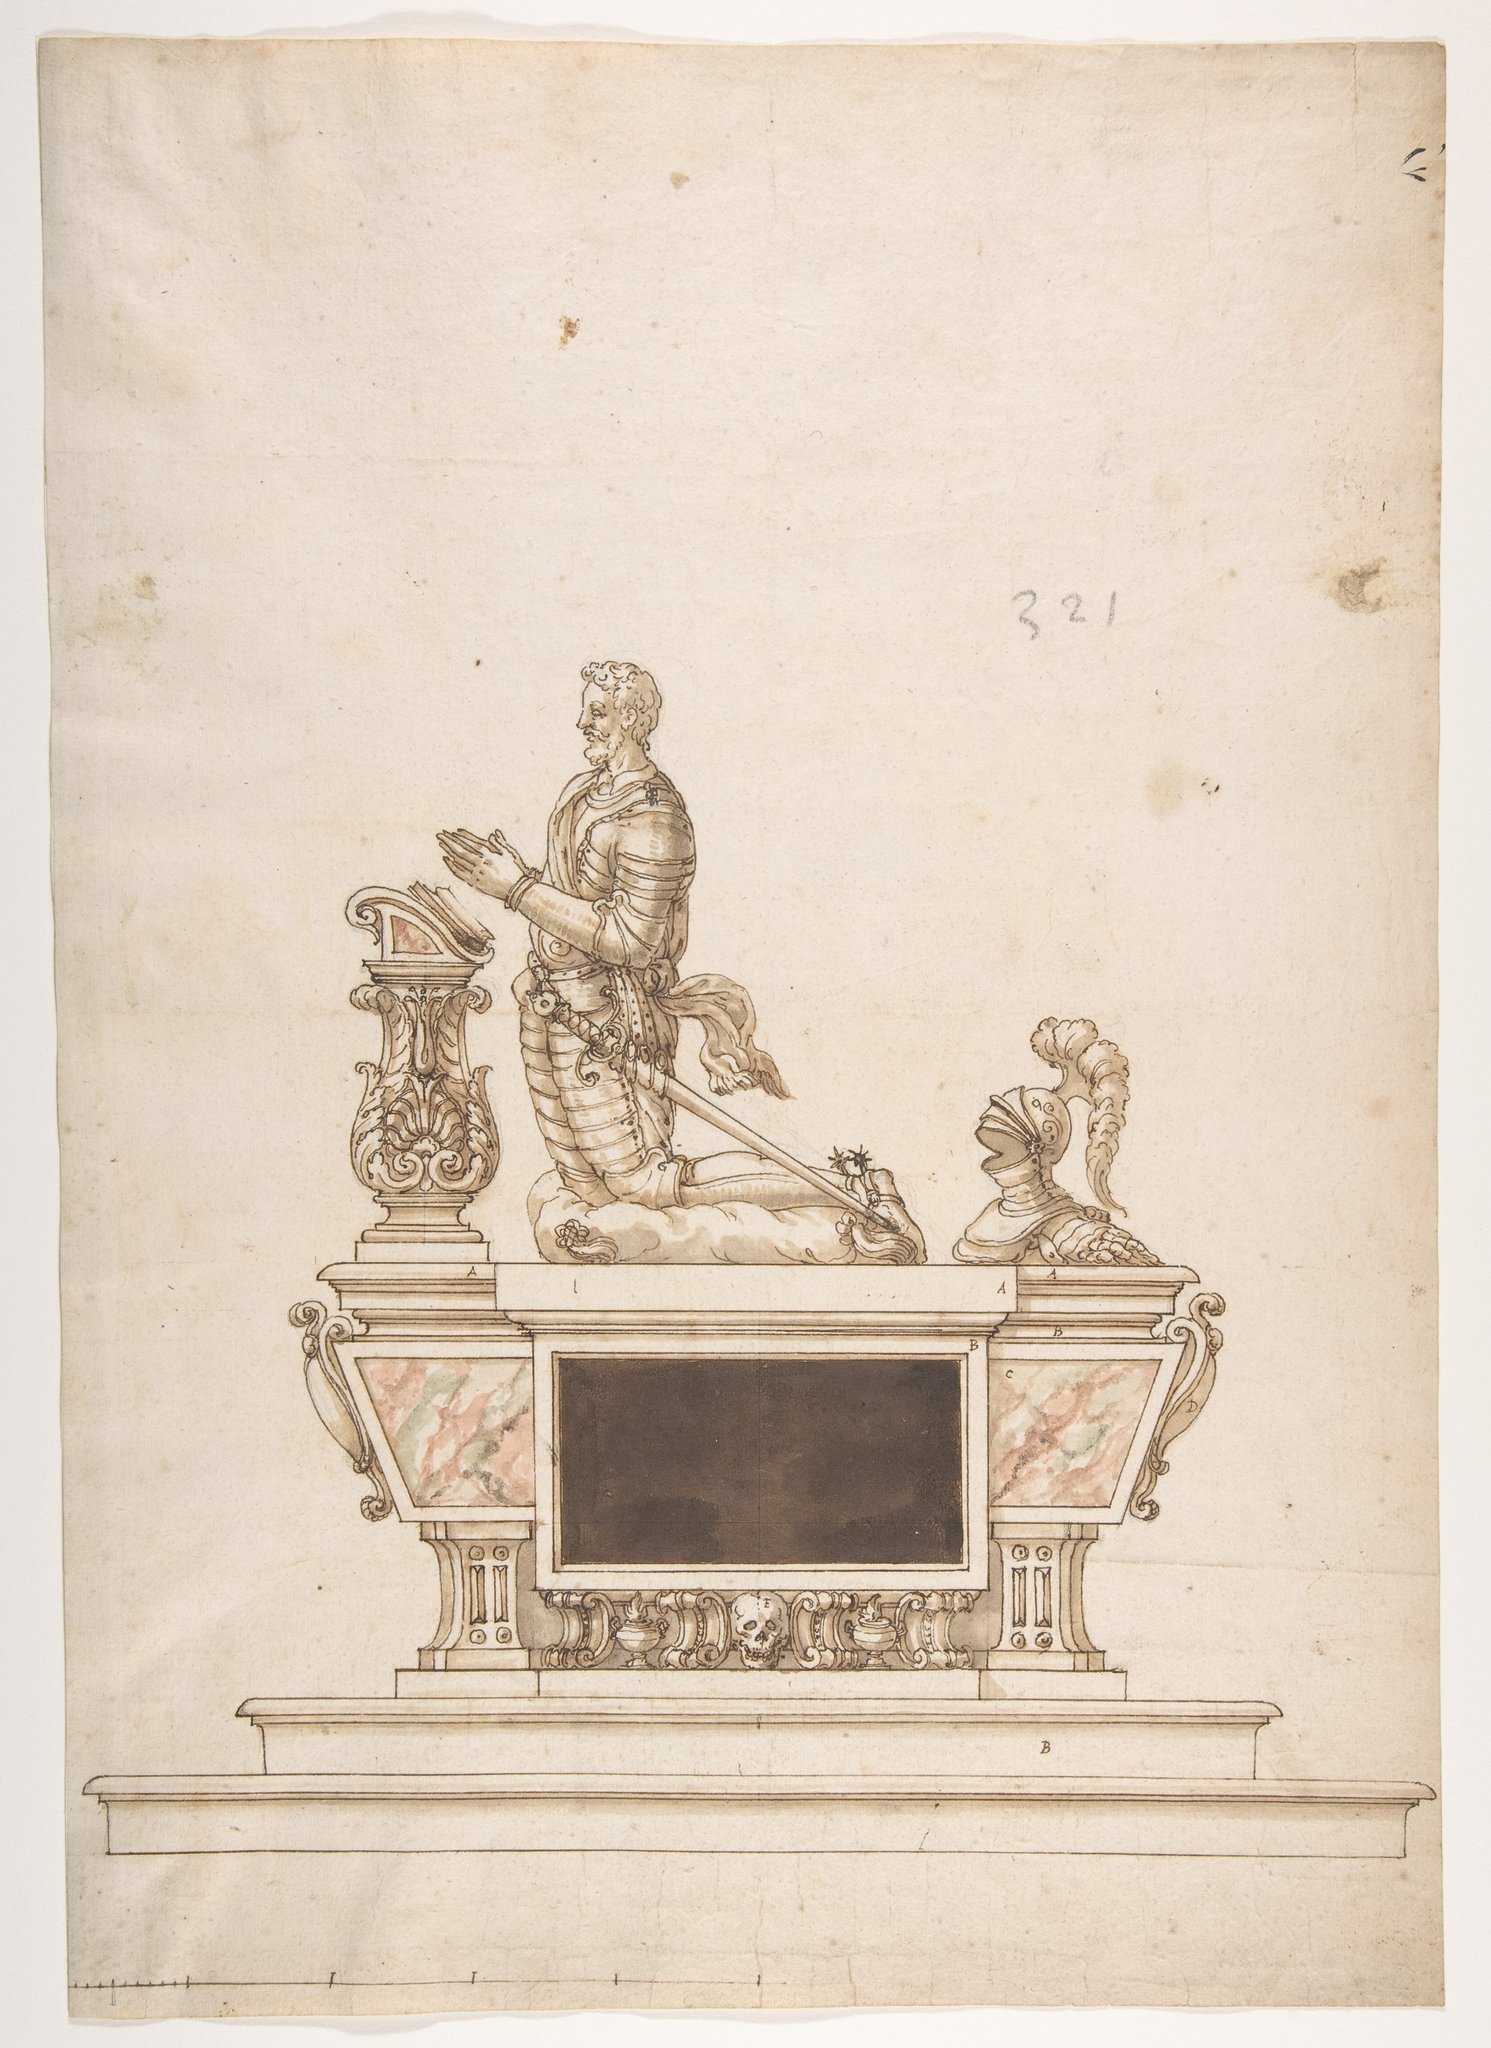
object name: drawing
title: Design for a Man's Tomb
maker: anonymous, french, 16th century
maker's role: artist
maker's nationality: french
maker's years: 1500-1600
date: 1501-1600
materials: chalk, ink, watercolor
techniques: brush, pen, wash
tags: tombs,swords,men